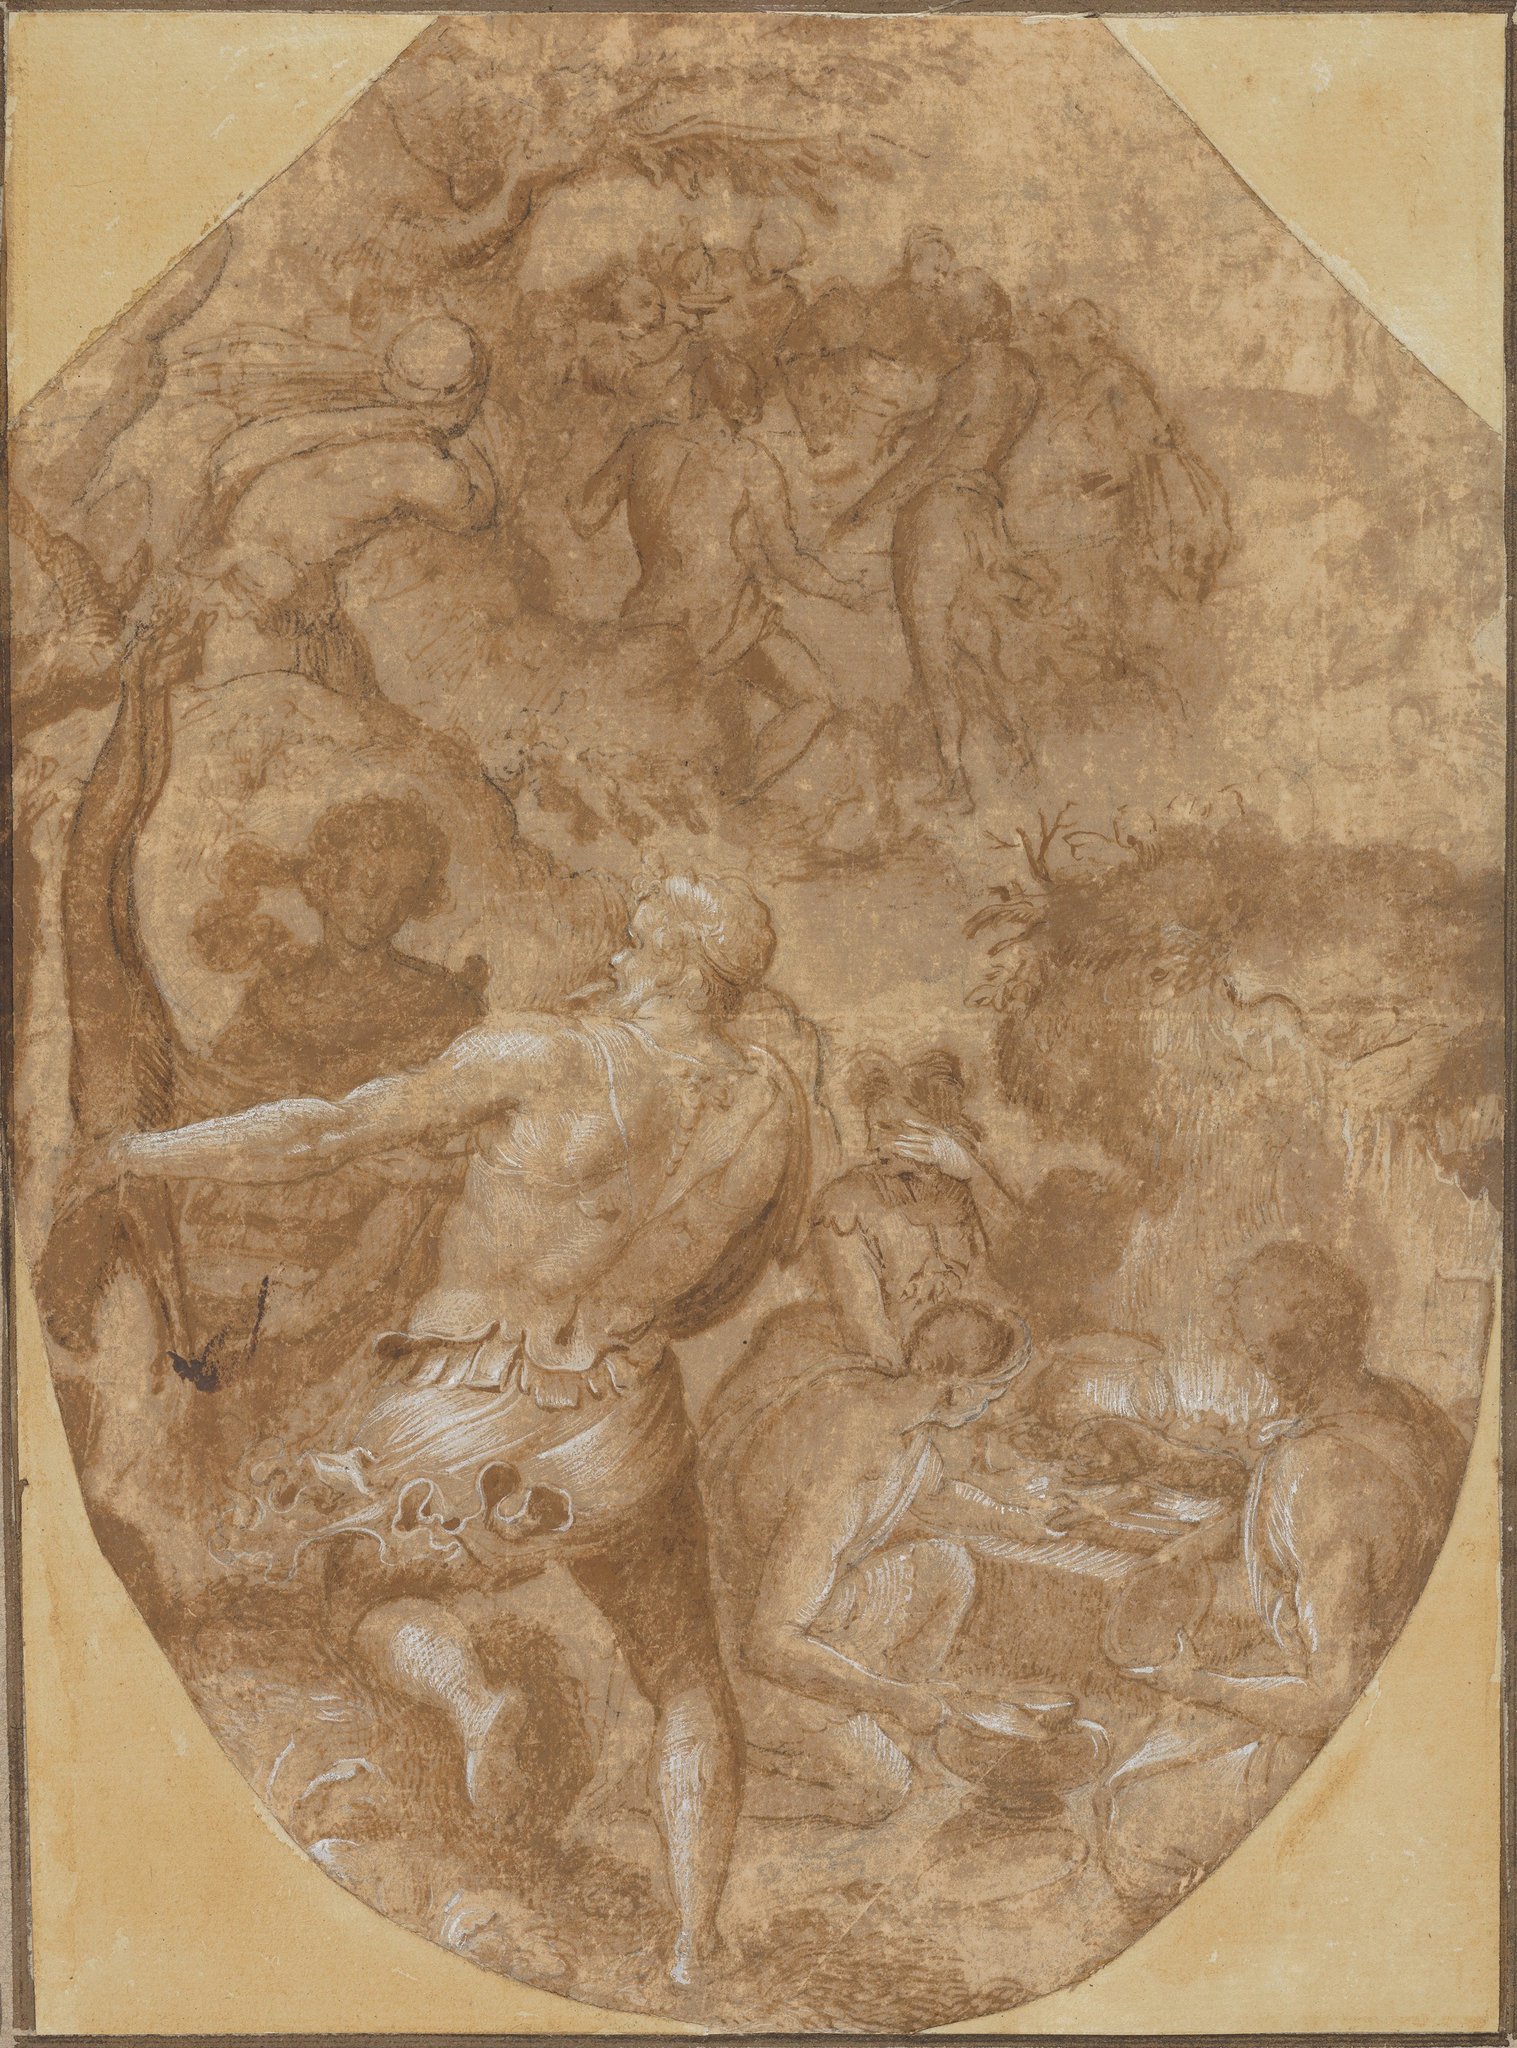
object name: drawing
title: The Discovery of Glass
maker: giovanni maria butteri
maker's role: artist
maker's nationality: italian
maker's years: 1540-1606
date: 1570-1572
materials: chalk, gouache, ink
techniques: brush, highlighting, pen, wash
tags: men,women